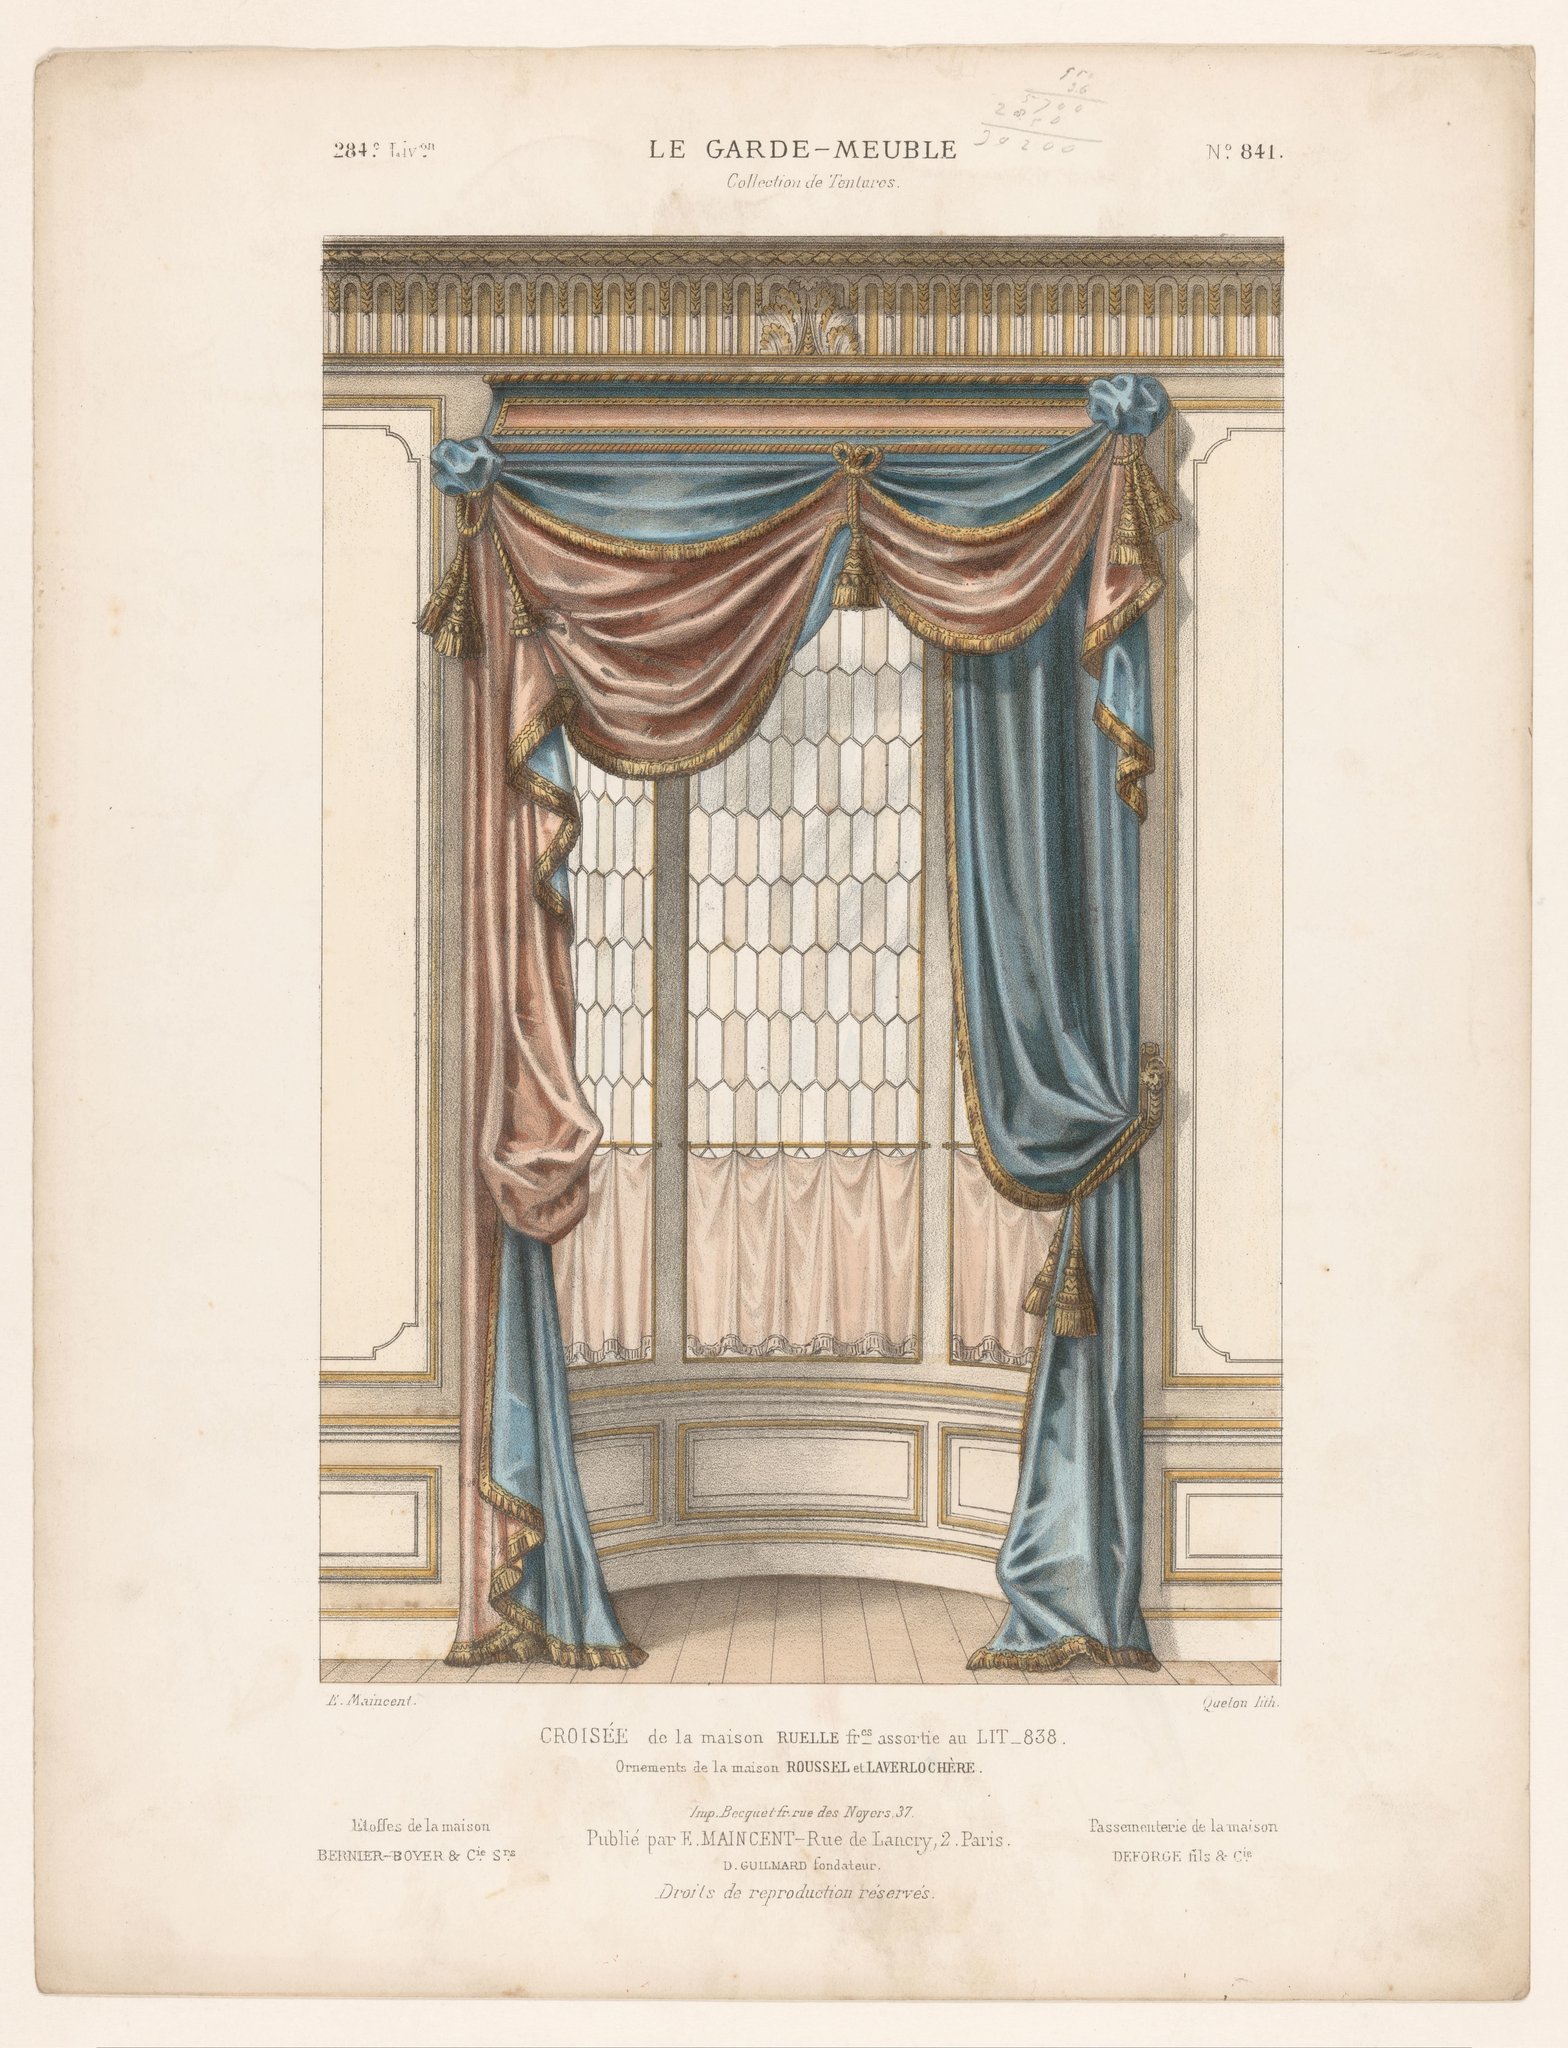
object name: print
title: Venster met gordijnen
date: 1885-1895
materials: paper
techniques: hand coloring, lithograph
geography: paris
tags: window, hangings and drapery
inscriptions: annotation, : ‘Droits de reproduction réservés.’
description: Kruisvenster van een alkoof met gedrapeerde gordijnen. De franjes komen overeen met die van het bed op nr. 838. Prent uit 284e Livraison.